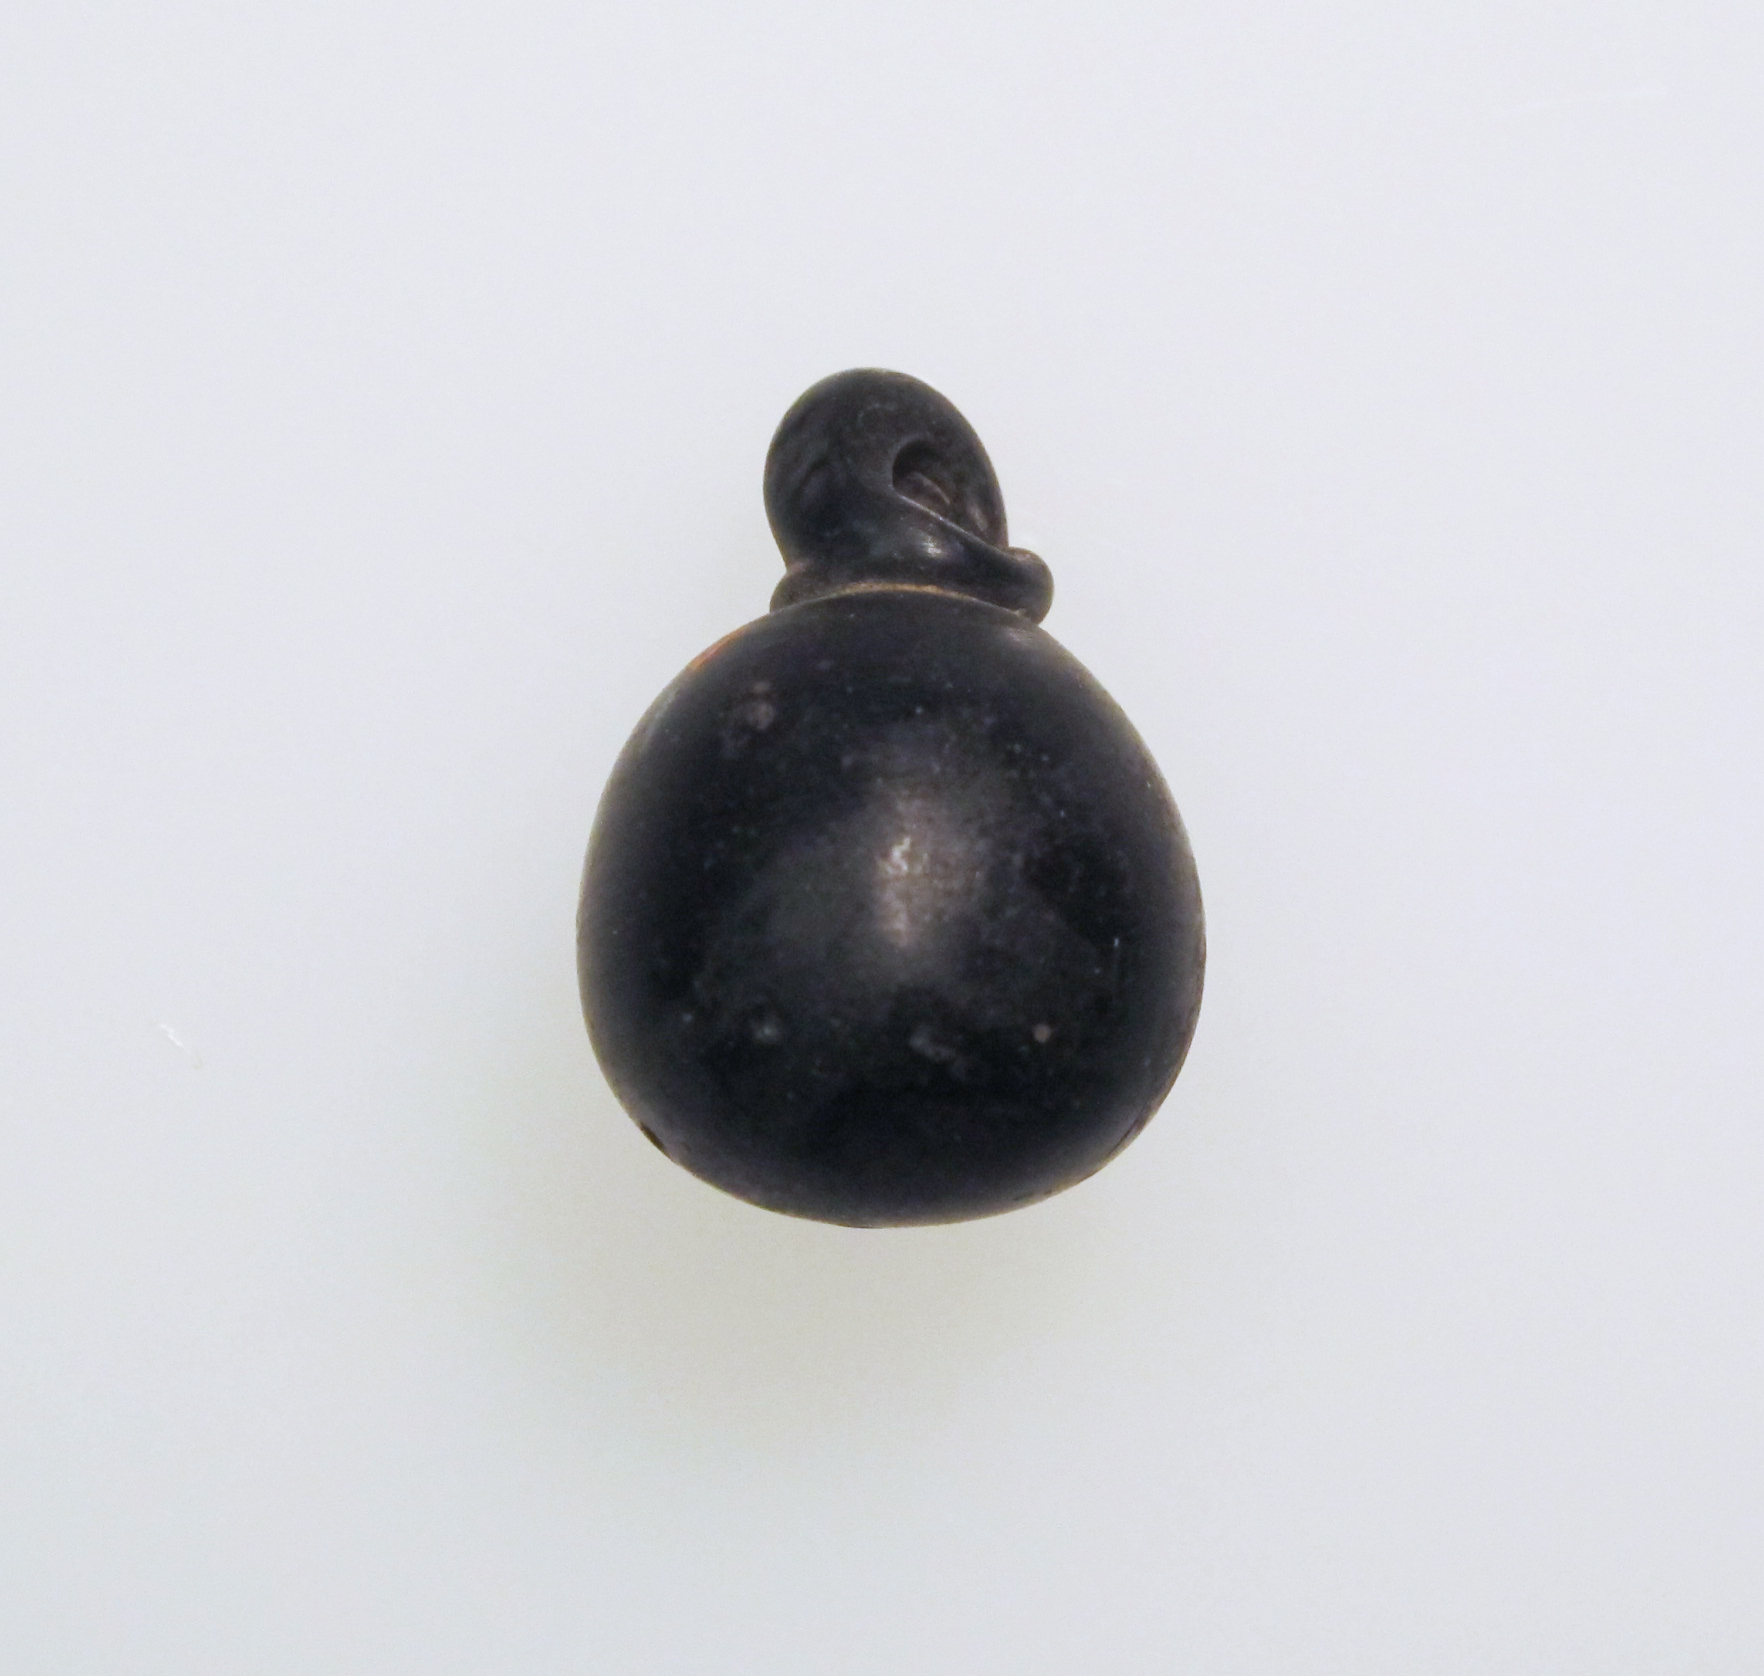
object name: pendant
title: Glass pendant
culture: roman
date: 201-400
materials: glass